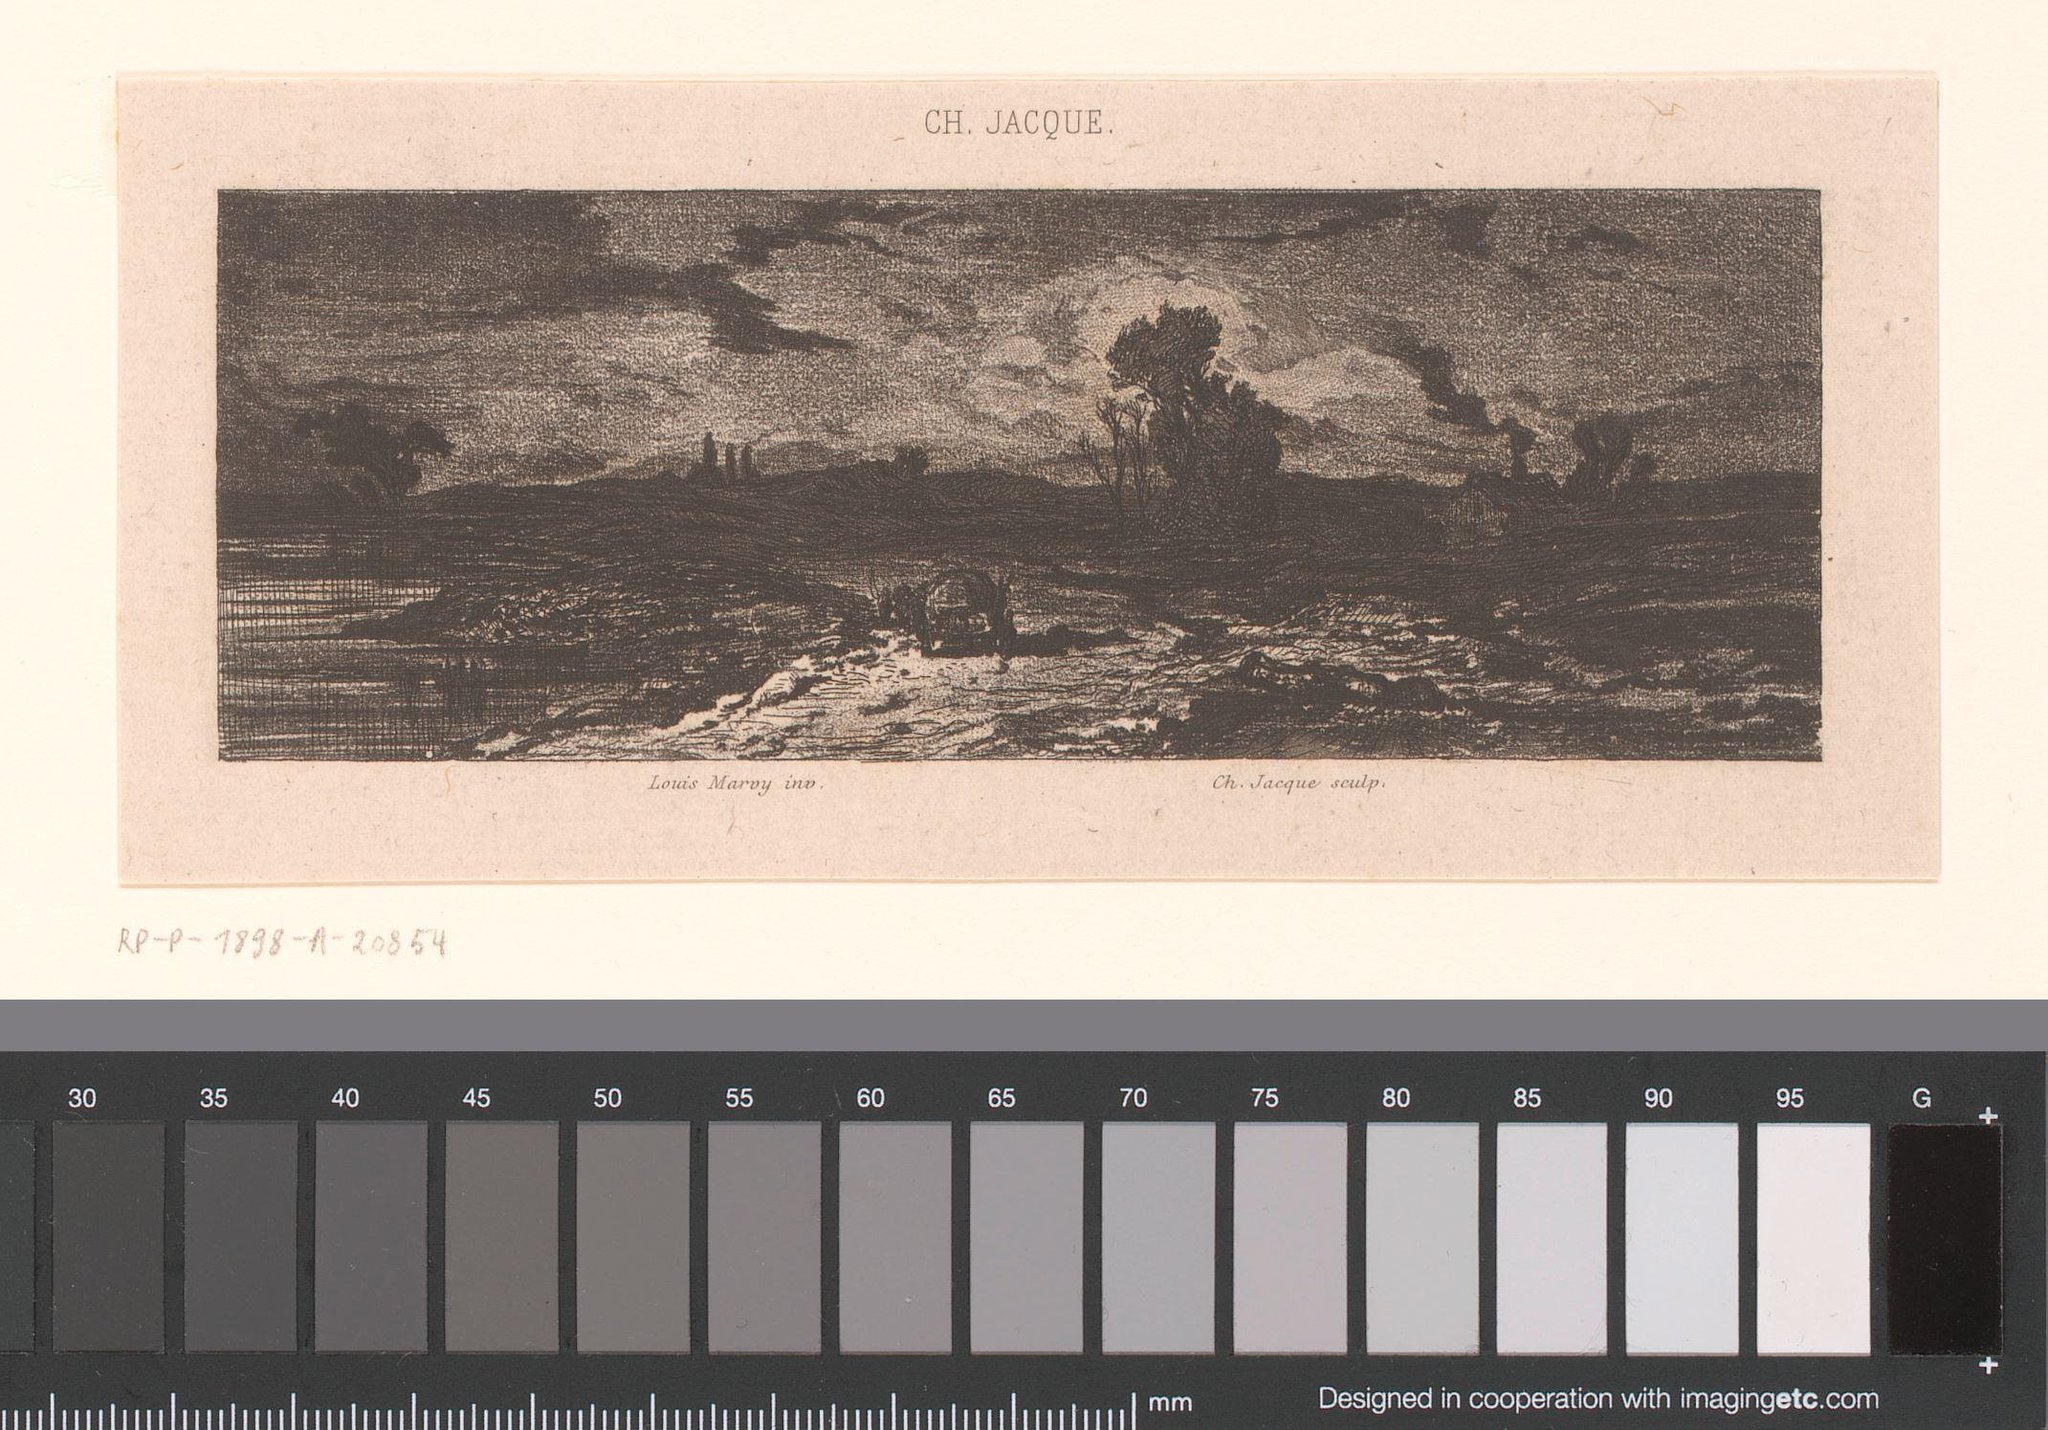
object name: print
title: Landschap in de schemering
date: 1841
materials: paper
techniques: drypoint, etching, roulette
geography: france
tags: dusk, evening twilight, water course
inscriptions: collector's mark: Lugt 964